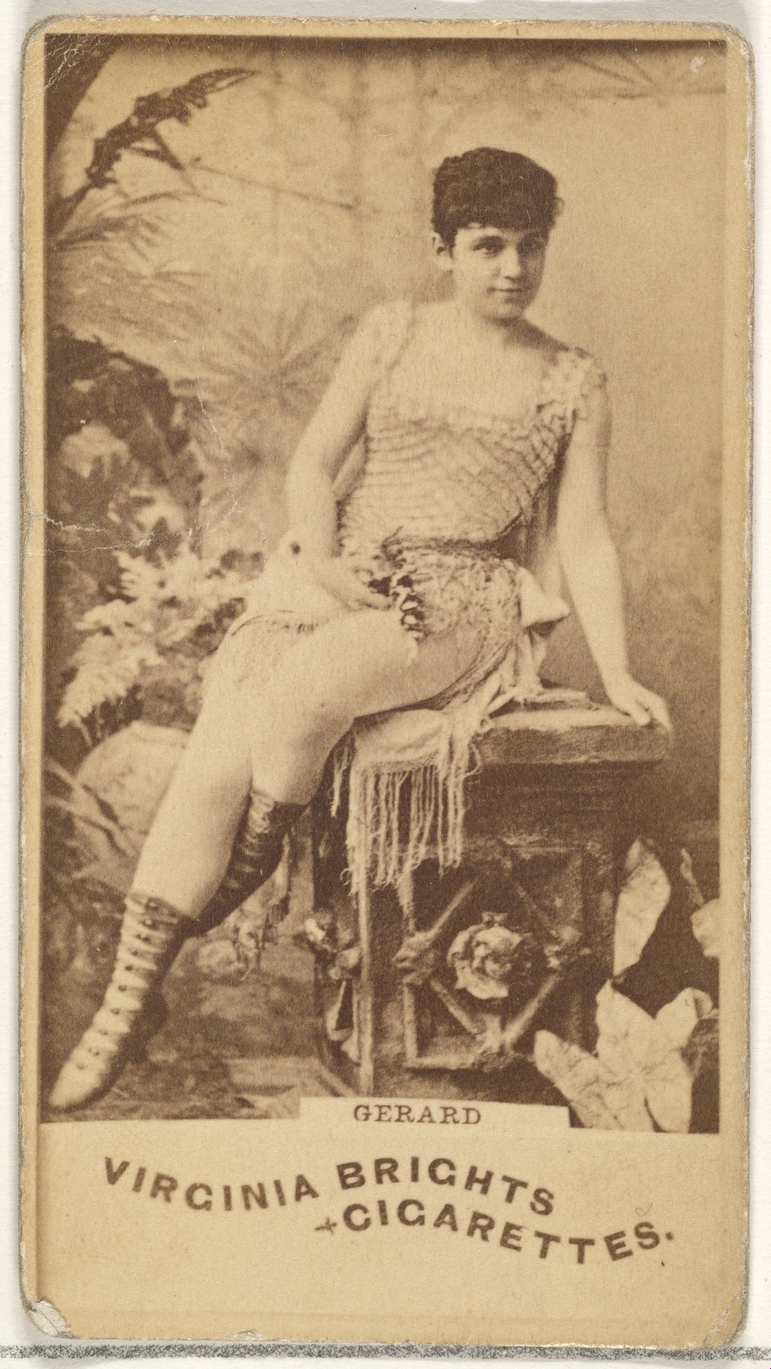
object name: photograph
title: Gerard, from the Actors and Actresses series (N45, Type 1) for Virginia Brights Cigarettes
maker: allen & ginter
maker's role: publisher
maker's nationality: american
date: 1888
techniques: albumen silver print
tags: portraits,women,actresses